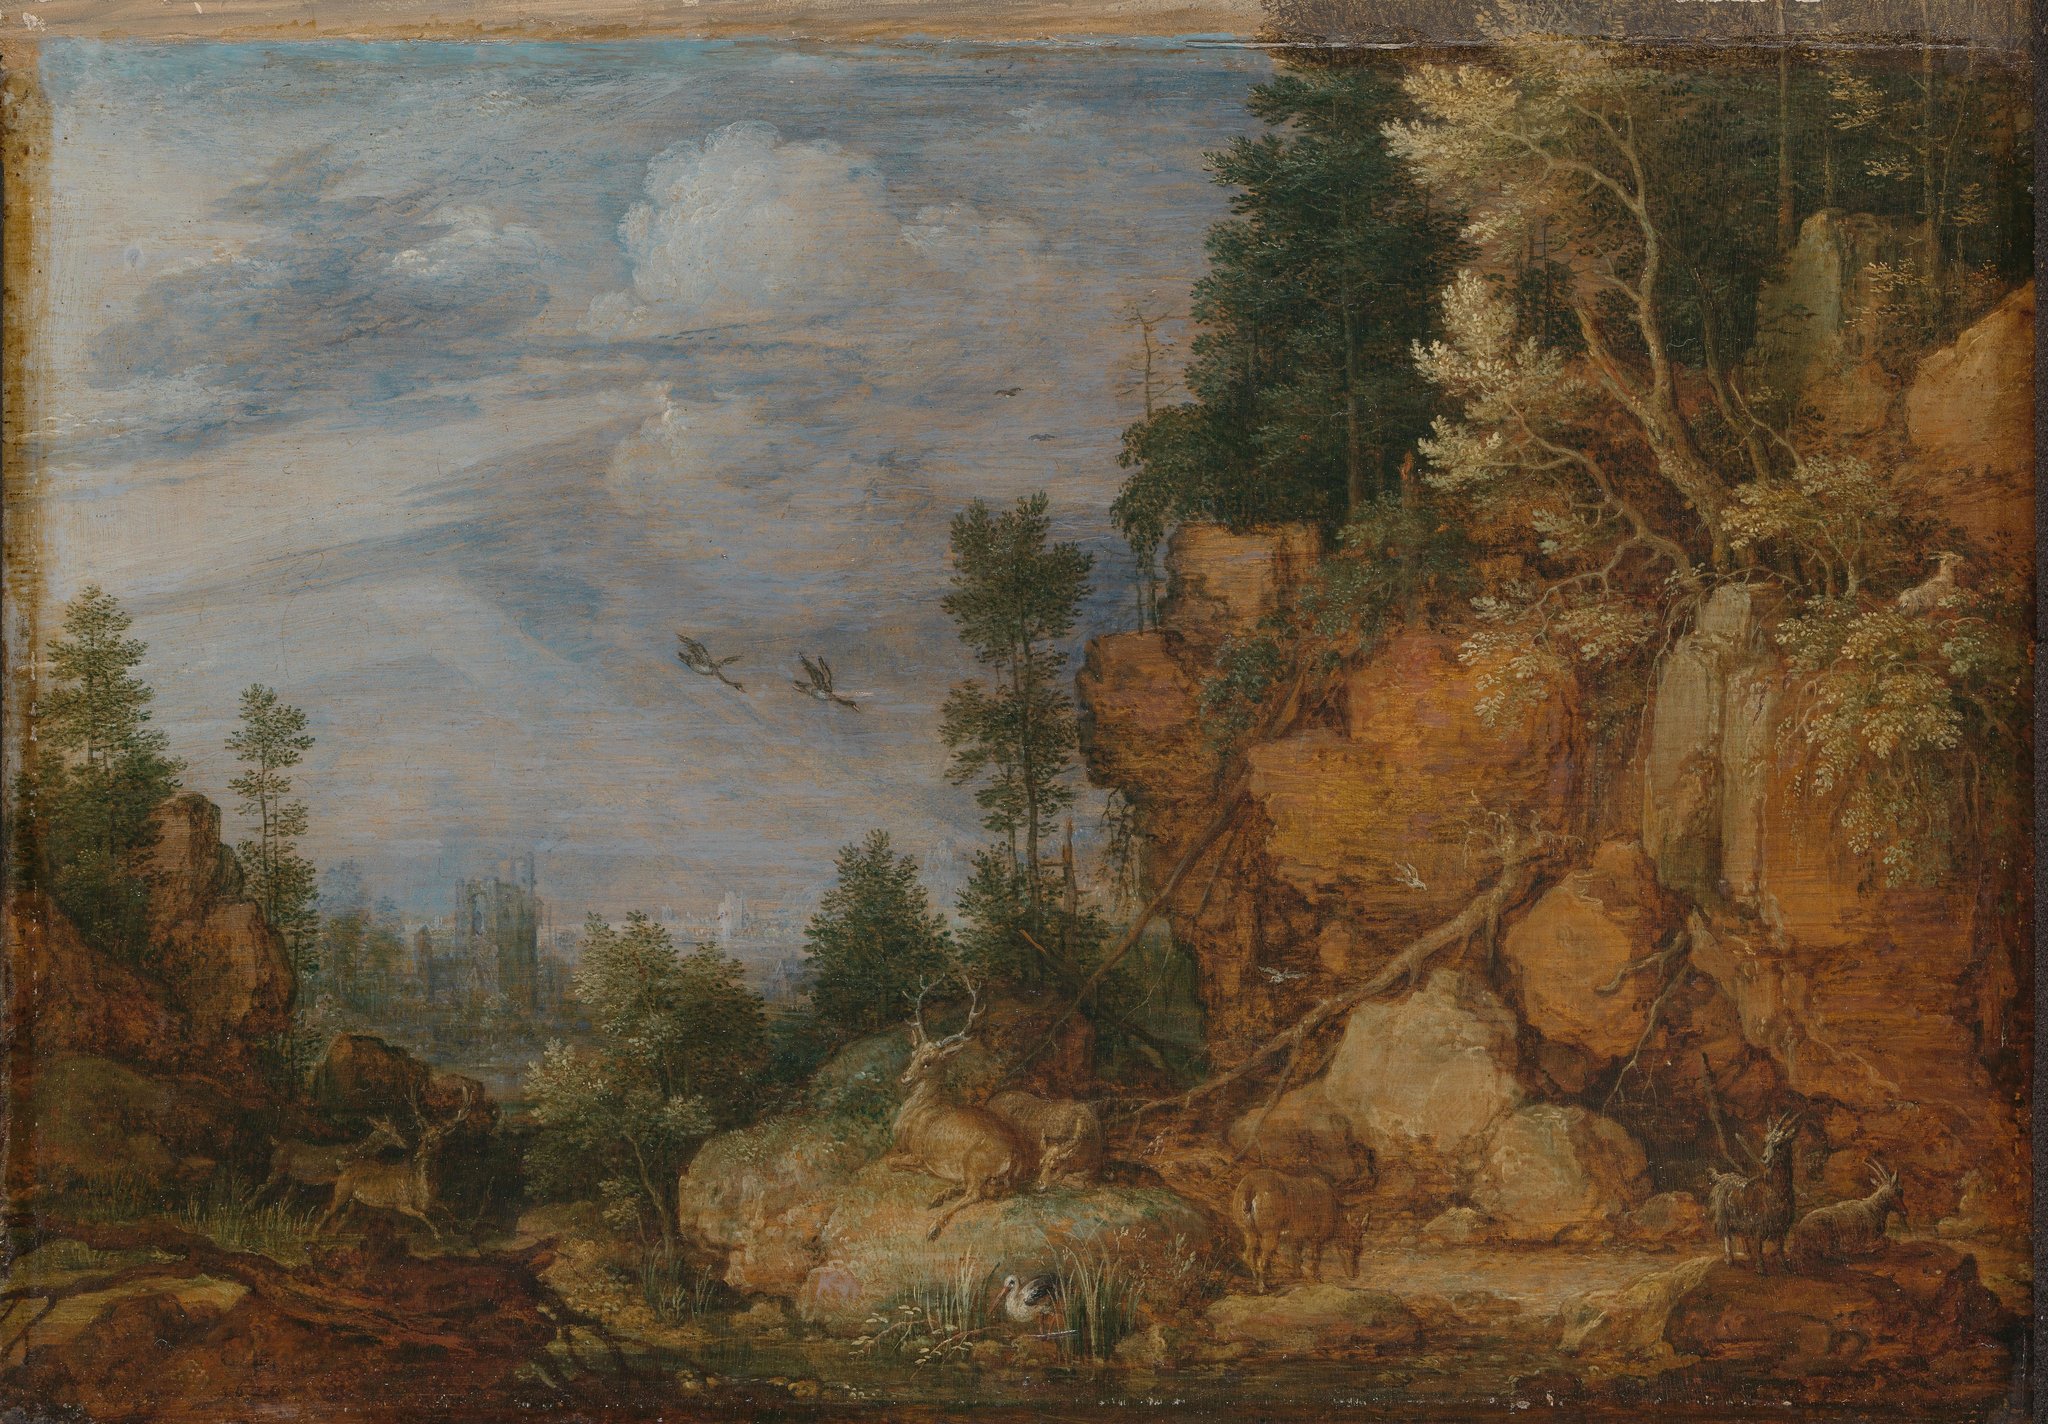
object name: painting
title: Rocky Landscape with Deer and Goats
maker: gillis claesz de hondecoeter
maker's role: draughtsman, painter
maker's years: 1575-1638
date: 1620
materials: oil, panel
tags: rocks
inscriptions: signature and date, bottom left (D and H ligated): ‘GDH 1620’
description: Rotsachtig landschap met herten en geiten. Op de voorgrond een beek, in de verte een ruïne. In de lucht vliegen twee ganzen.